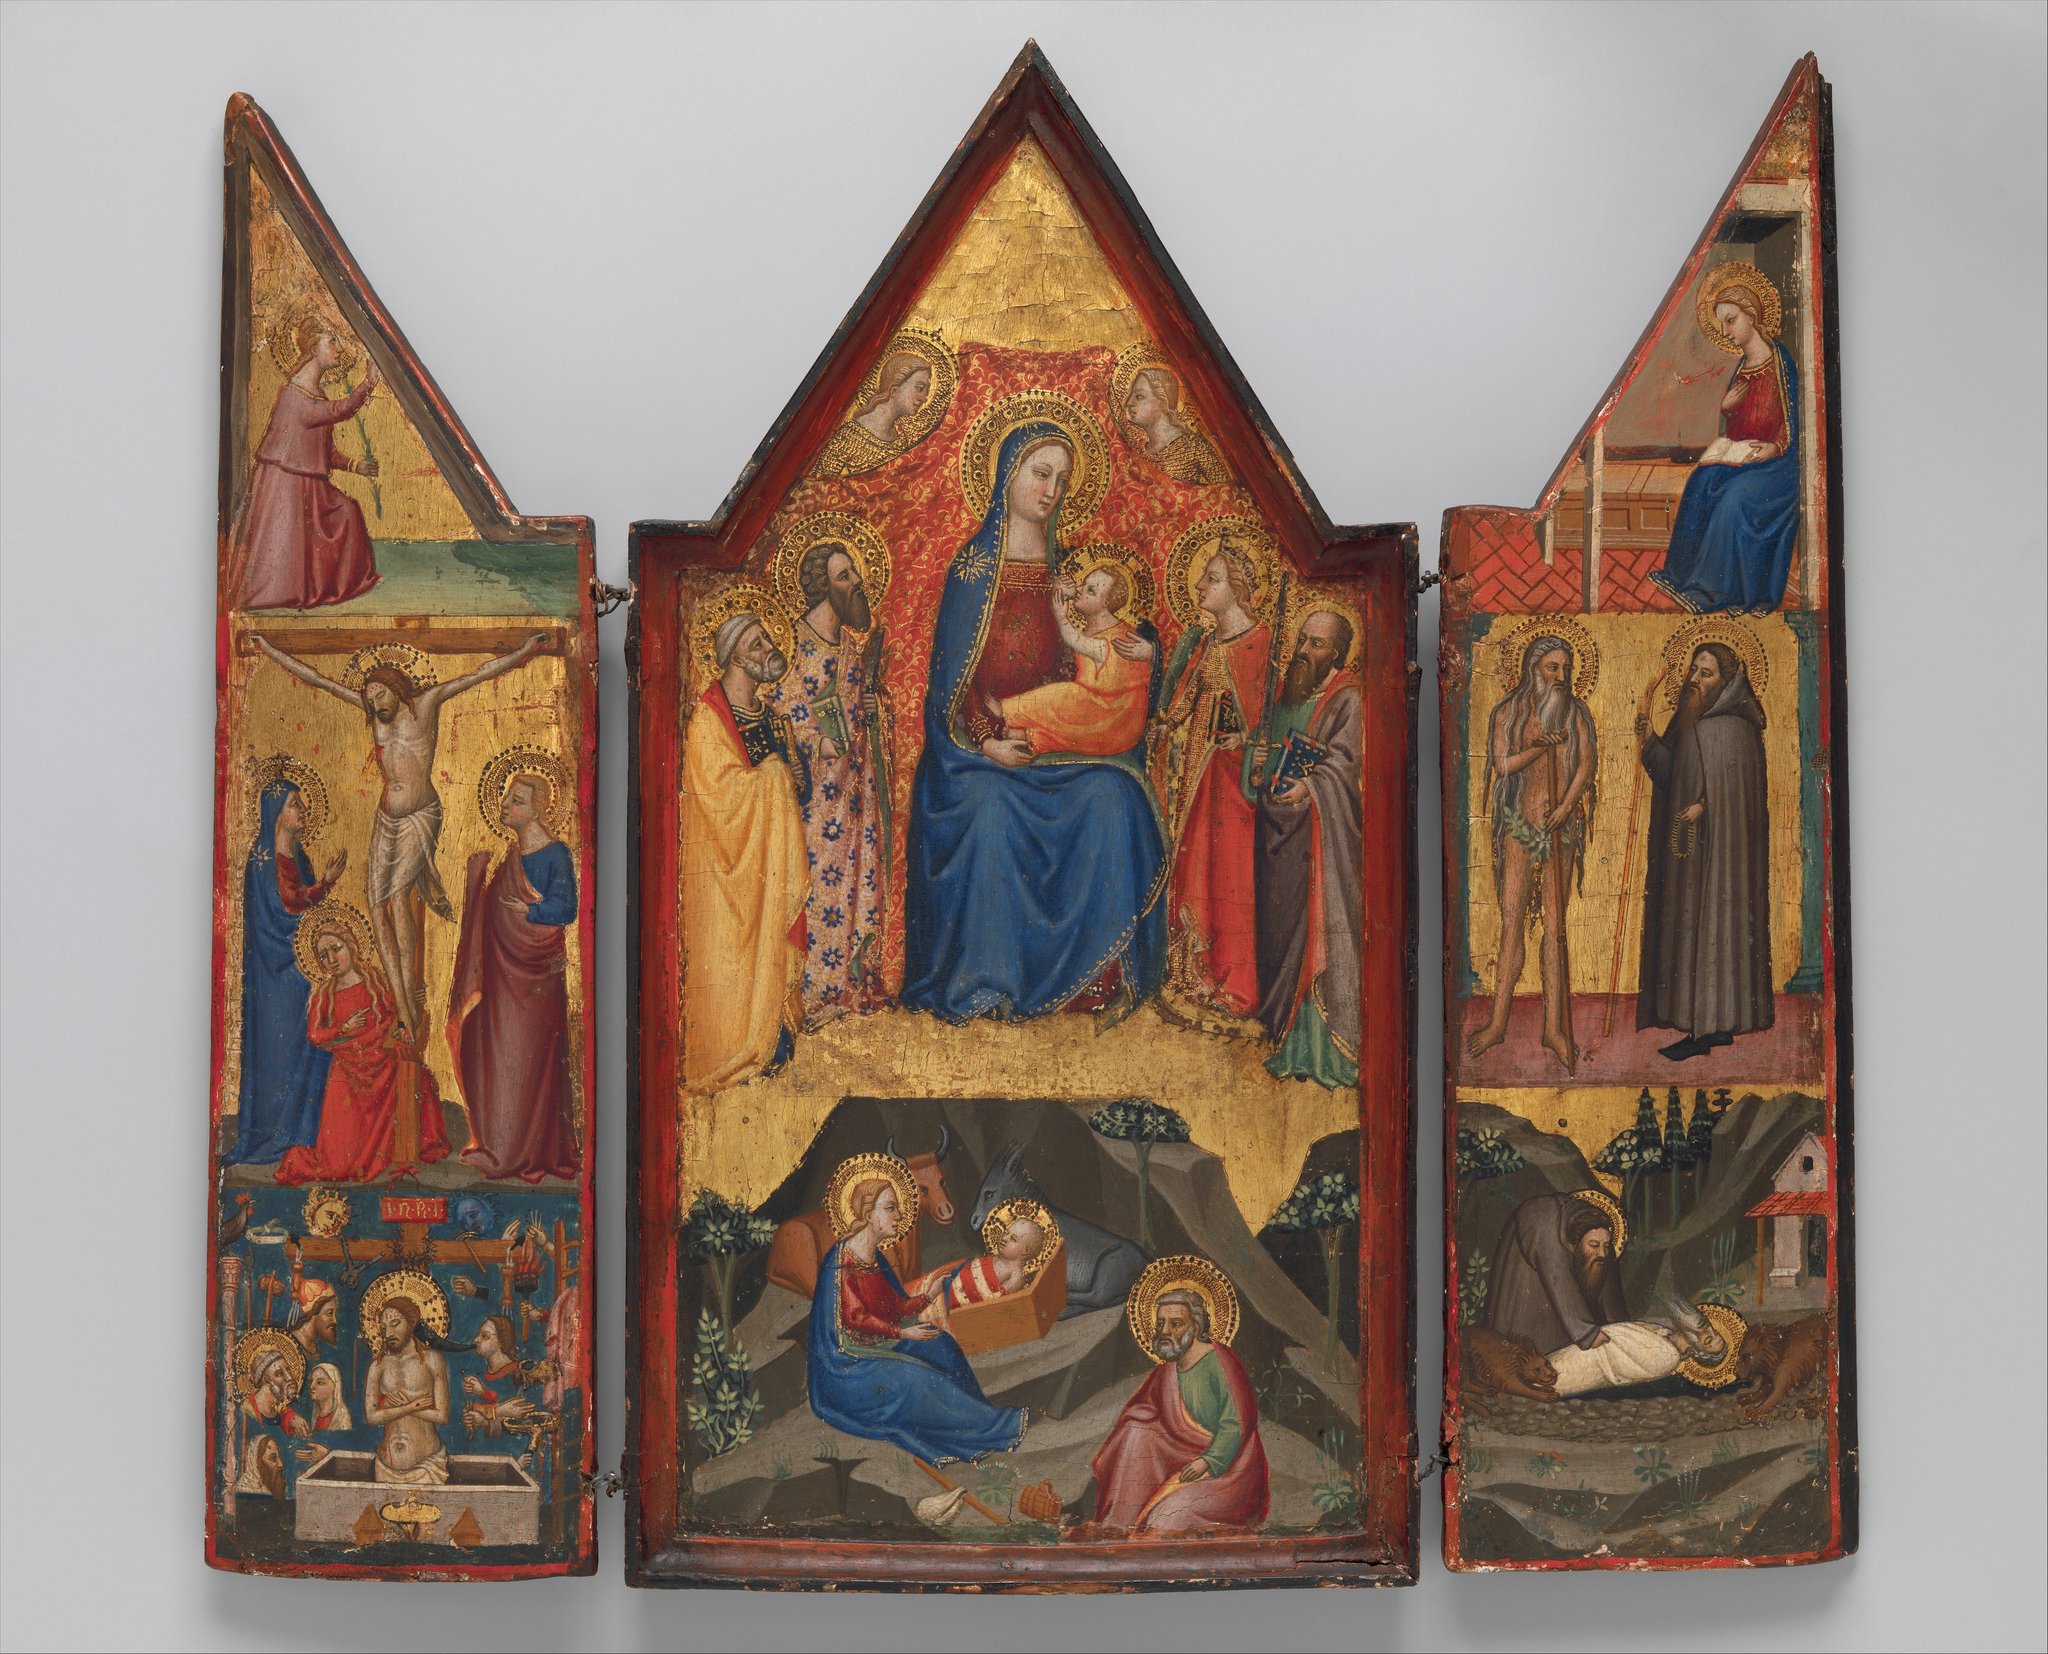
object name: frame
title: Triptych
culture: italian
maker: tuscany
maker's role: artist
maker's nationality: tuscany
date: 1385-1390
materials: wood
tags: madonna and child,crucifixion